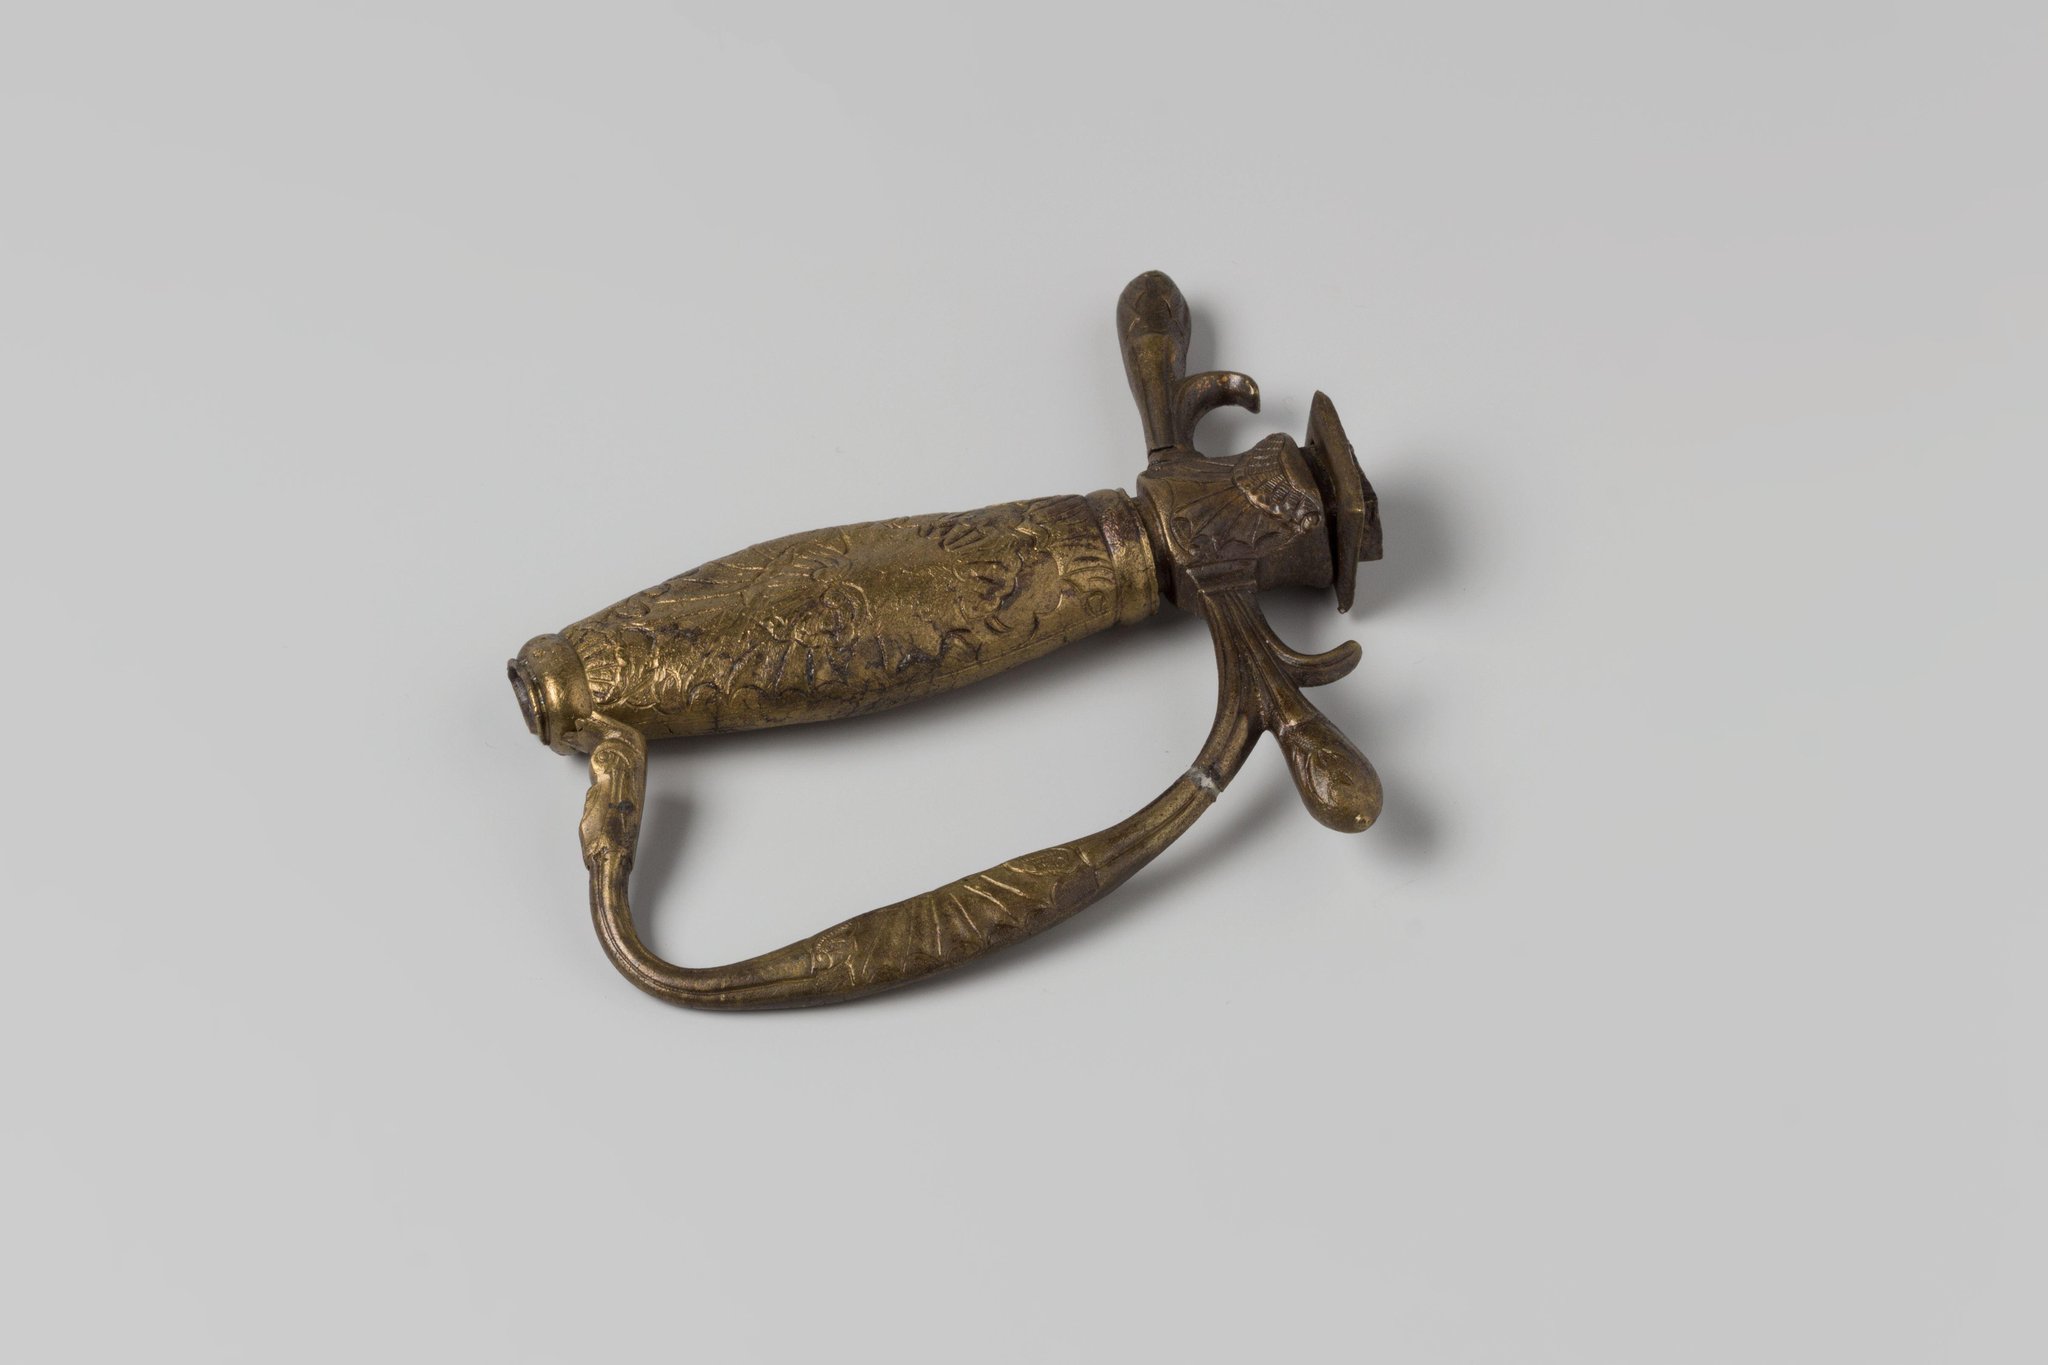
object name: beugel gevestl, gevestbeugel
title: Knuckle guard of a sword from the wreck of the Dutch East Indiaman Hollandia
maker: Anonymous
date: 1700-1743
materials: copper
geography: netherlands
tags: verenigde oostindische compagnie, hollandia (schip), annet